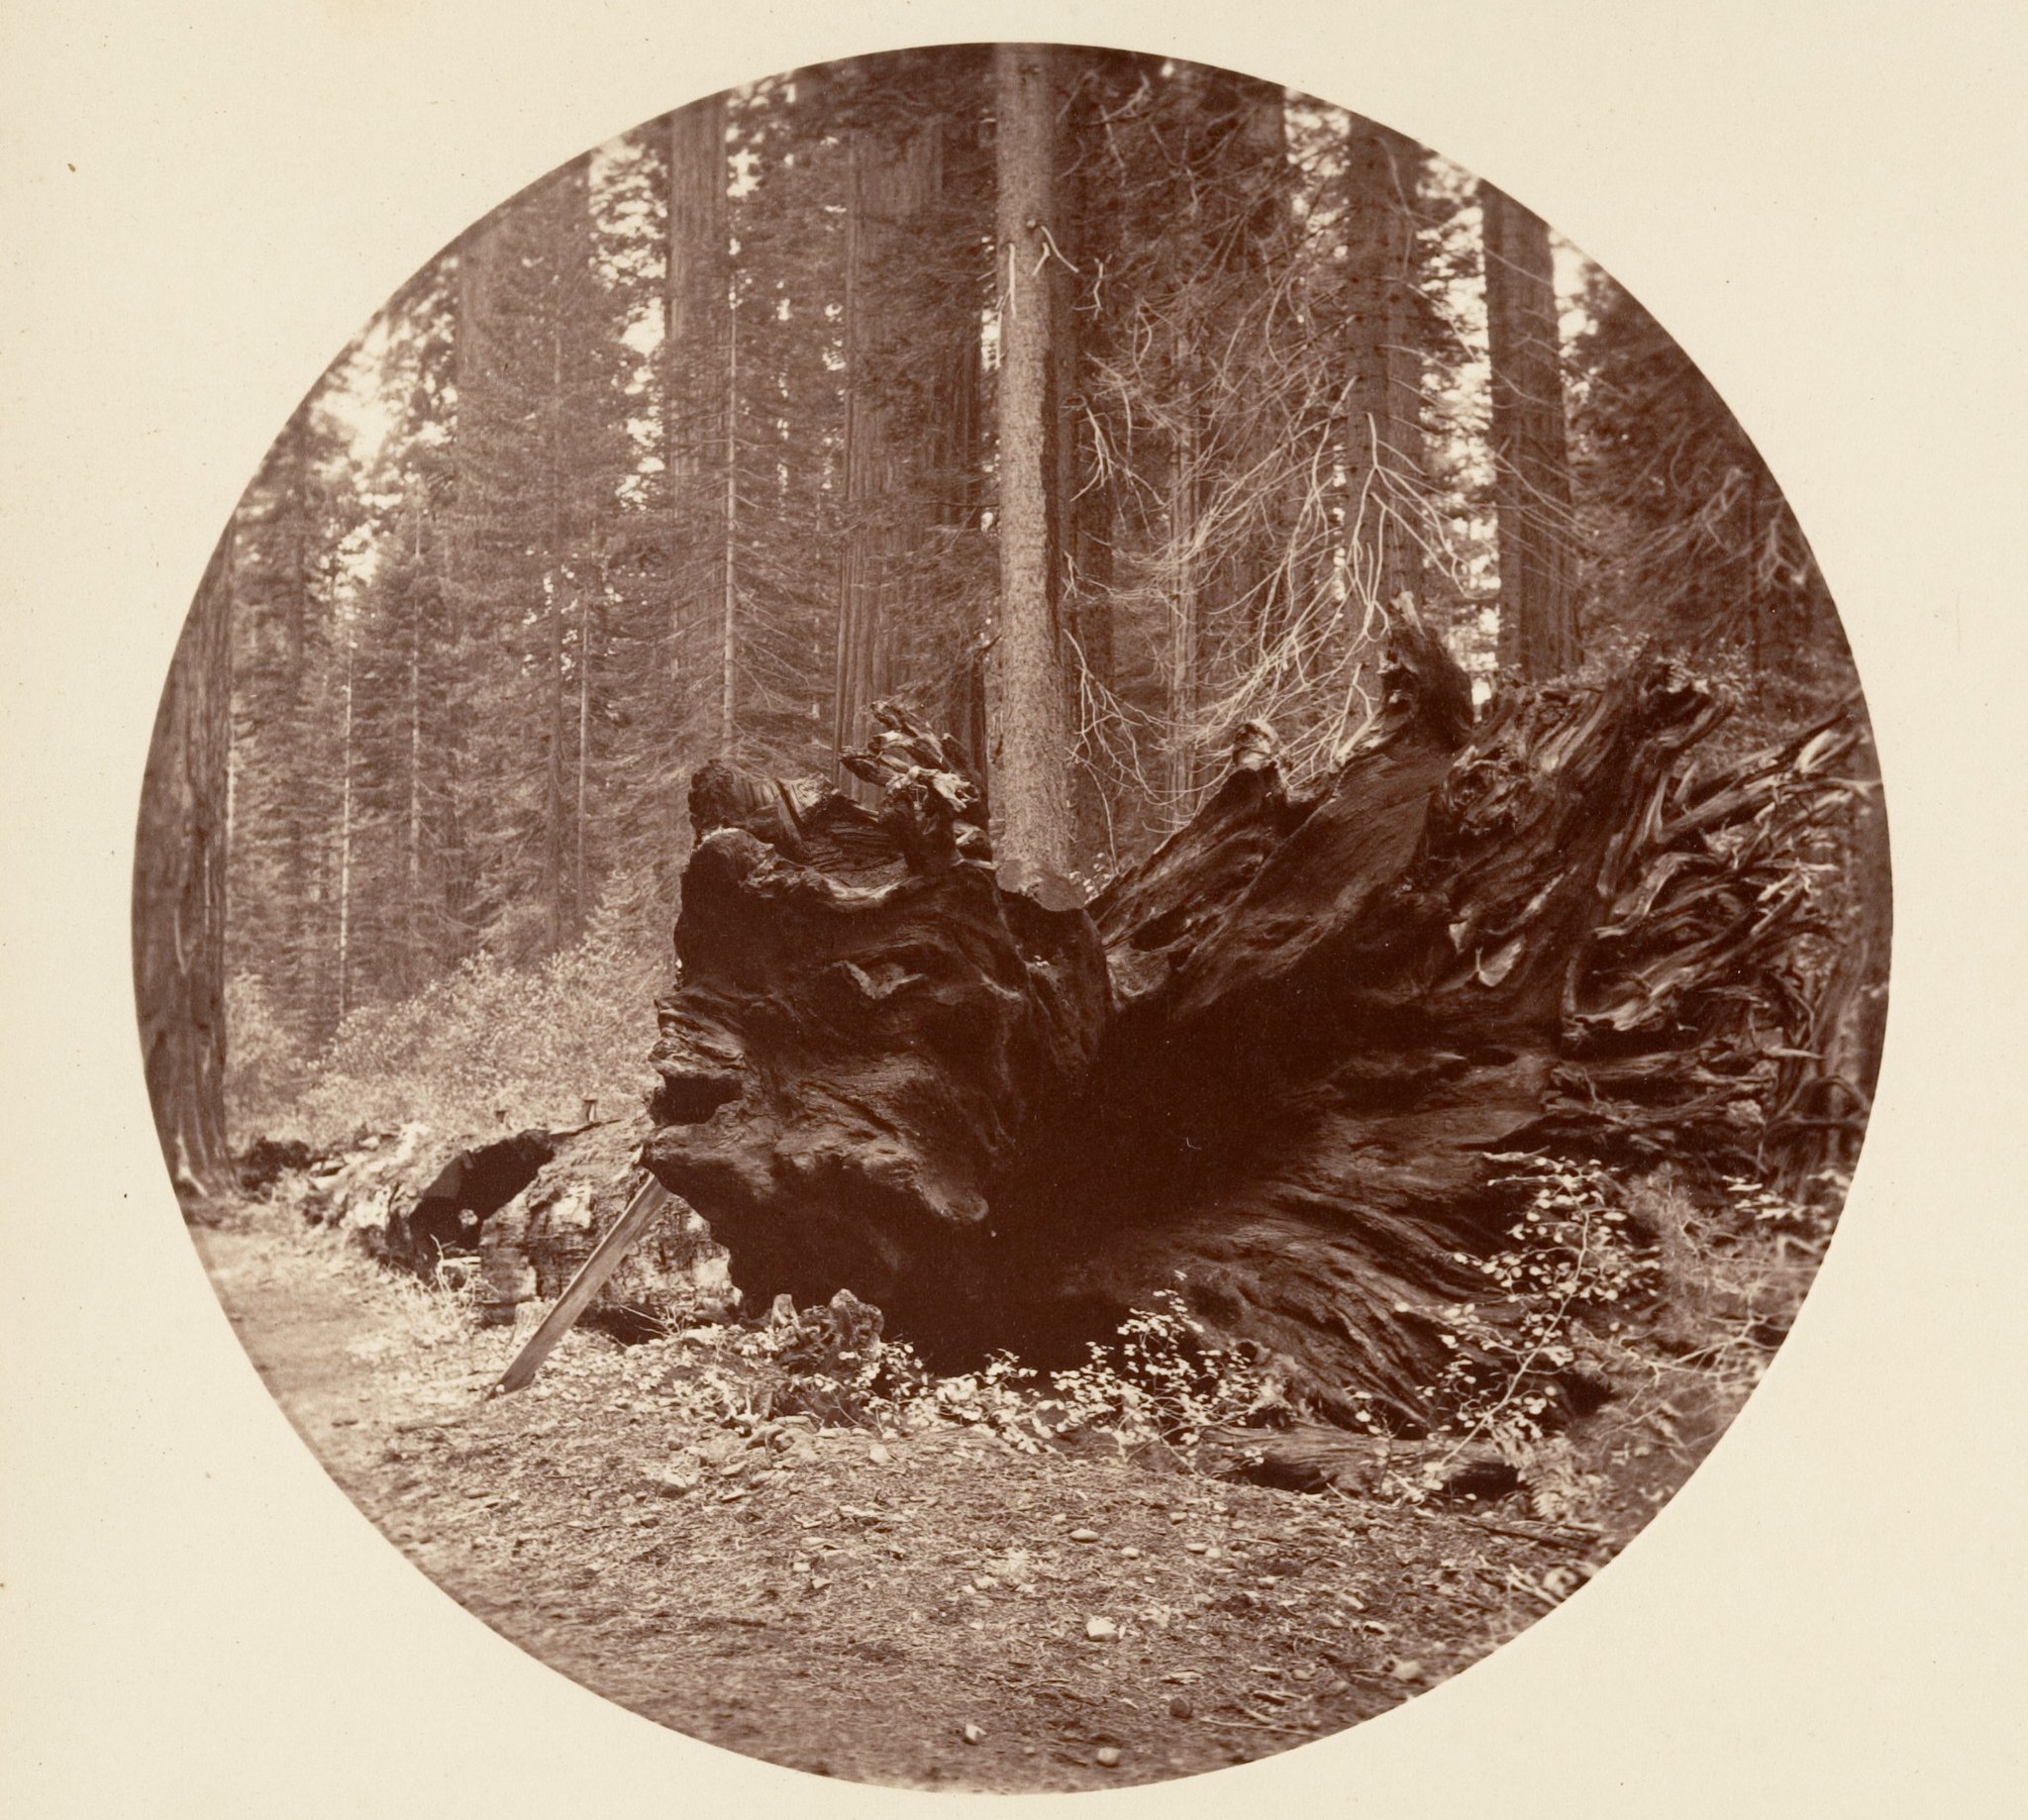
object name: photograph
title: The Father of the Forest 450 ft C. Grove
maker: carleton e. watkins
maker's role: artist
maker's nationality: american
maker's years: 1829-1916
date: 1878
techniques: albumen silver print, glass negative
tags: forests,trees